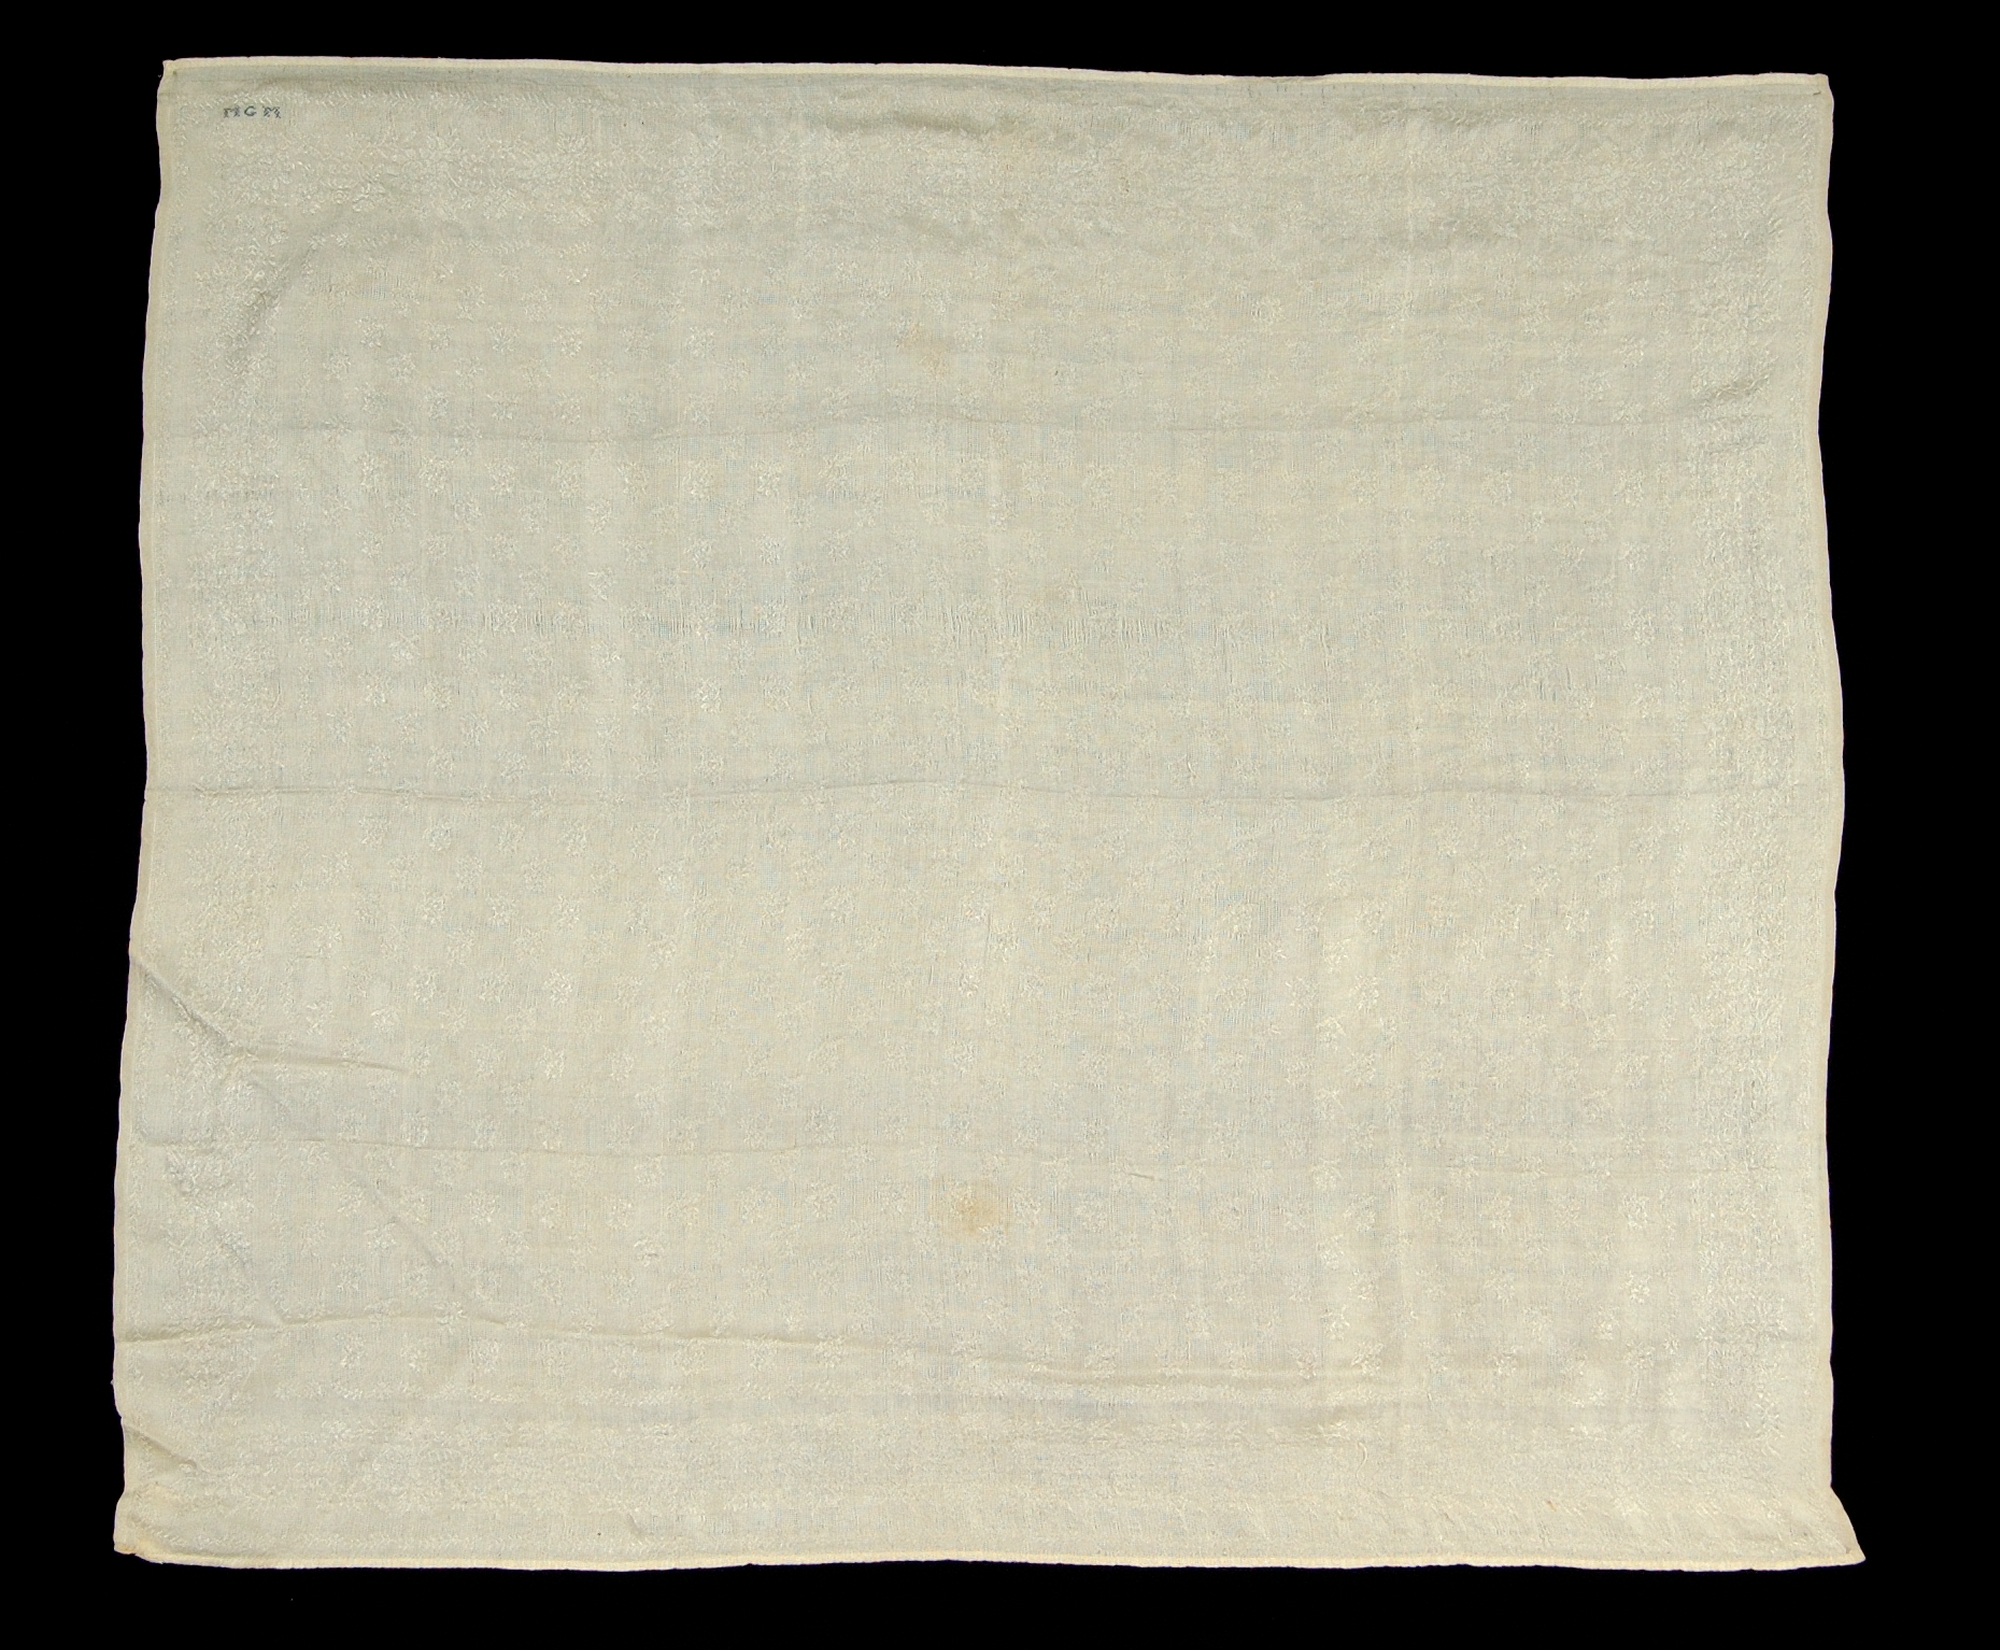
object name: handkerchief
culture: american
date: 1840-1860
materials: silk